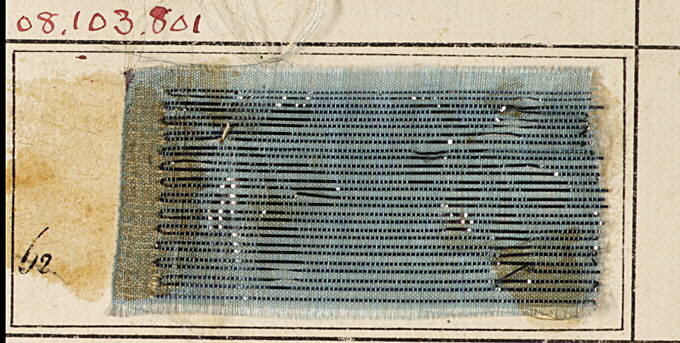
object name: ribbon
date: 1701-1900